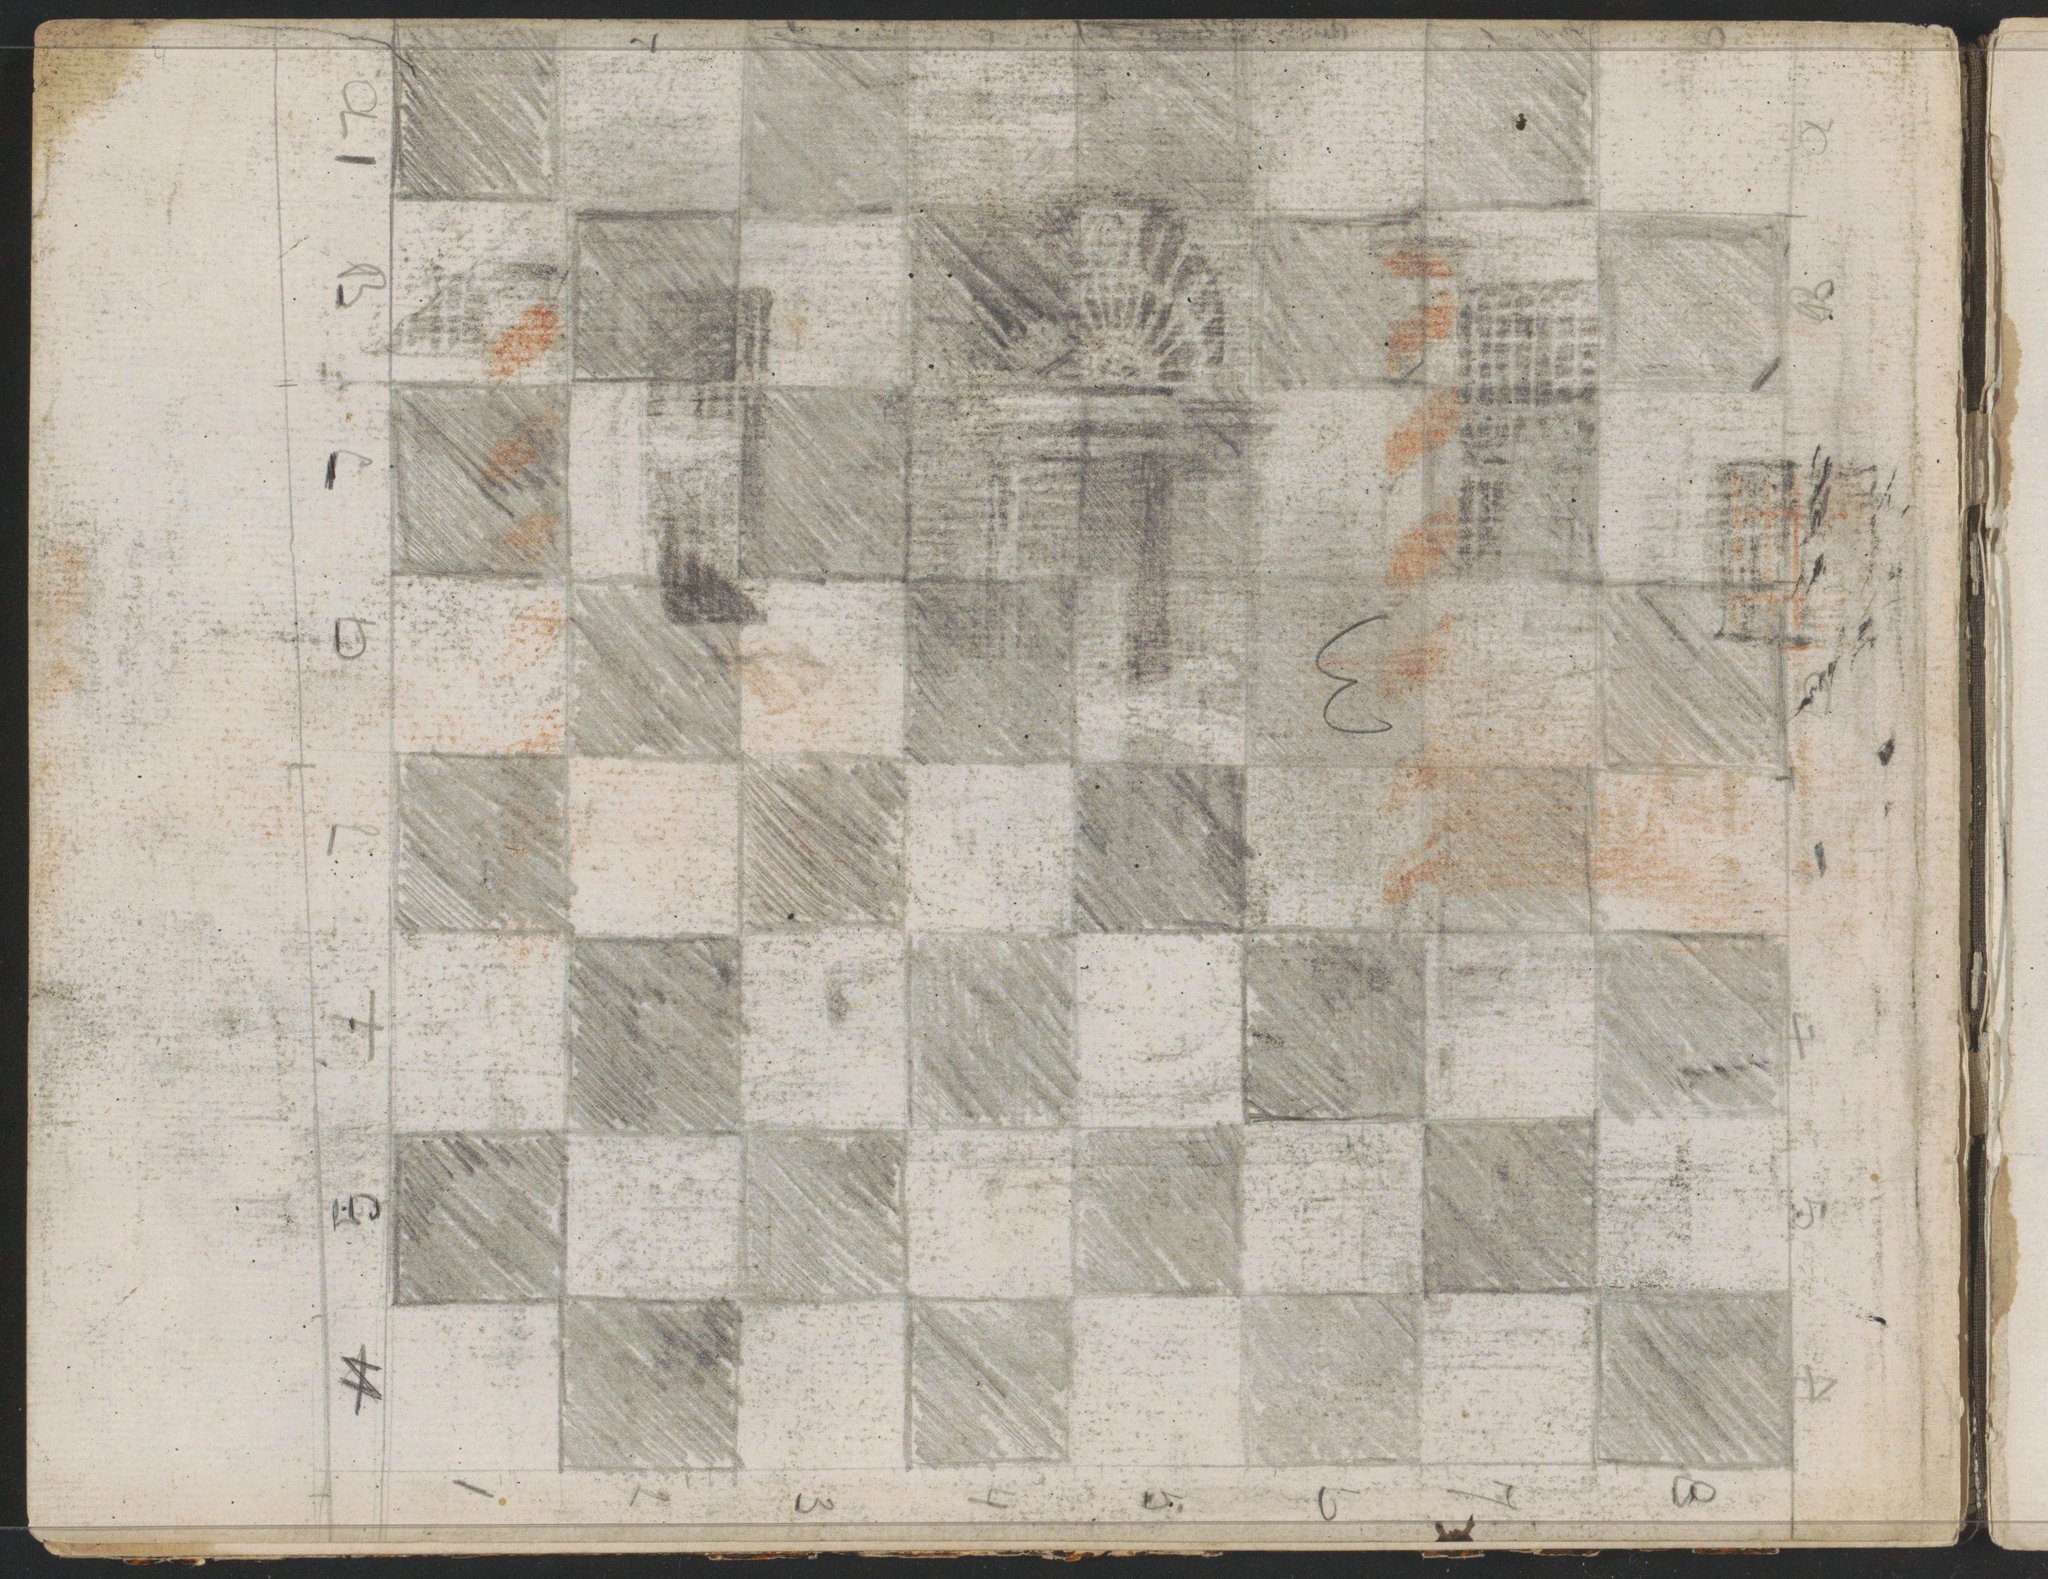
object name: sketchbook leaf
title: Schaakbordpatroon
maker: willem witsen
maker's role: draughtsman, painter, print maker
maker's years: 1860-1923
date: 1910-1915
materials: paper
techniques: printmaking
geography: san francisco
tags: chess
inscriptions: annotation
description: Verder mogelijk een abklatsch van architectuurstudies. Pagina 4 uit een schetsboek met 18 bladen.